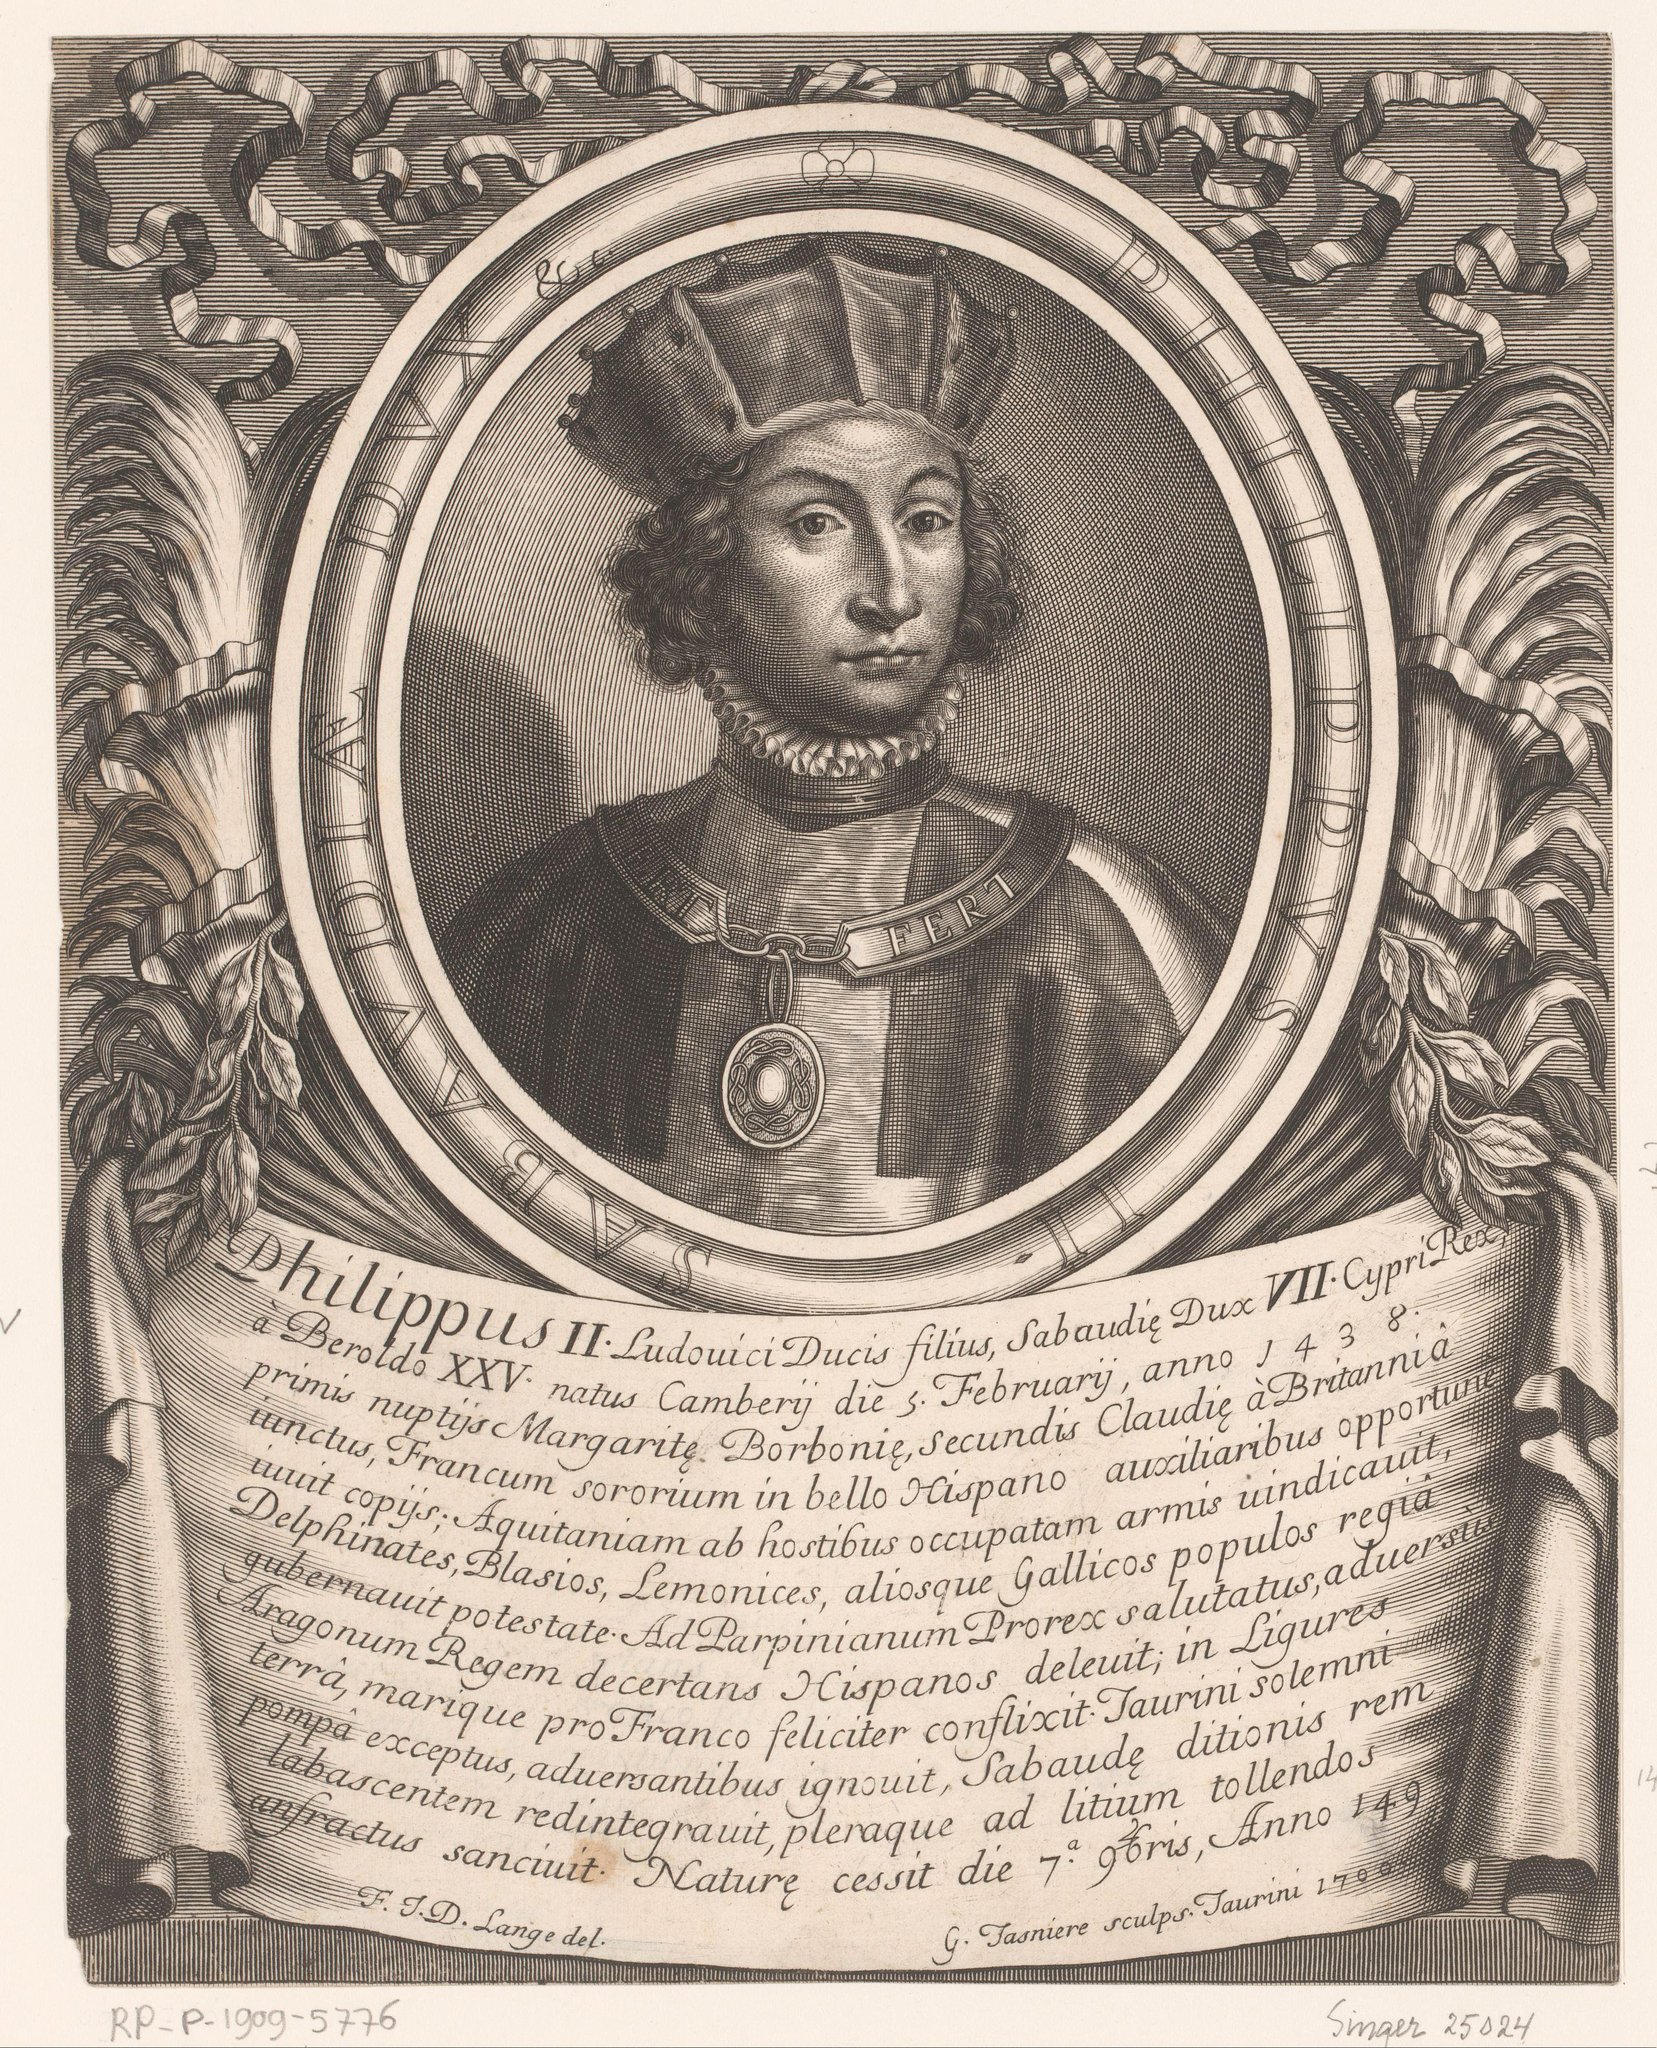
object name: print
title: Portret van Filips II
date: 1700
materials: paper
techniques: engraving, etching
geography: turin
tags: historical persons (portraits and scenes from the life) (+ (full) bust portrait)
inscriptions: collector's mark: Lugt 2228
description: Maakt deel uit van een serie getiteld 'Augustae regiaeque Sabaudae domus Arbor gentilitia regiae celsitudini Victori Amedeo II' met portretten door Giffart en Tasnière van leden van het Huis van Savoye, uitgegeven in 1702 door Francesco Maria Ferrero di Lavriano. Serienummer afgesneden: wellicht 25/?.